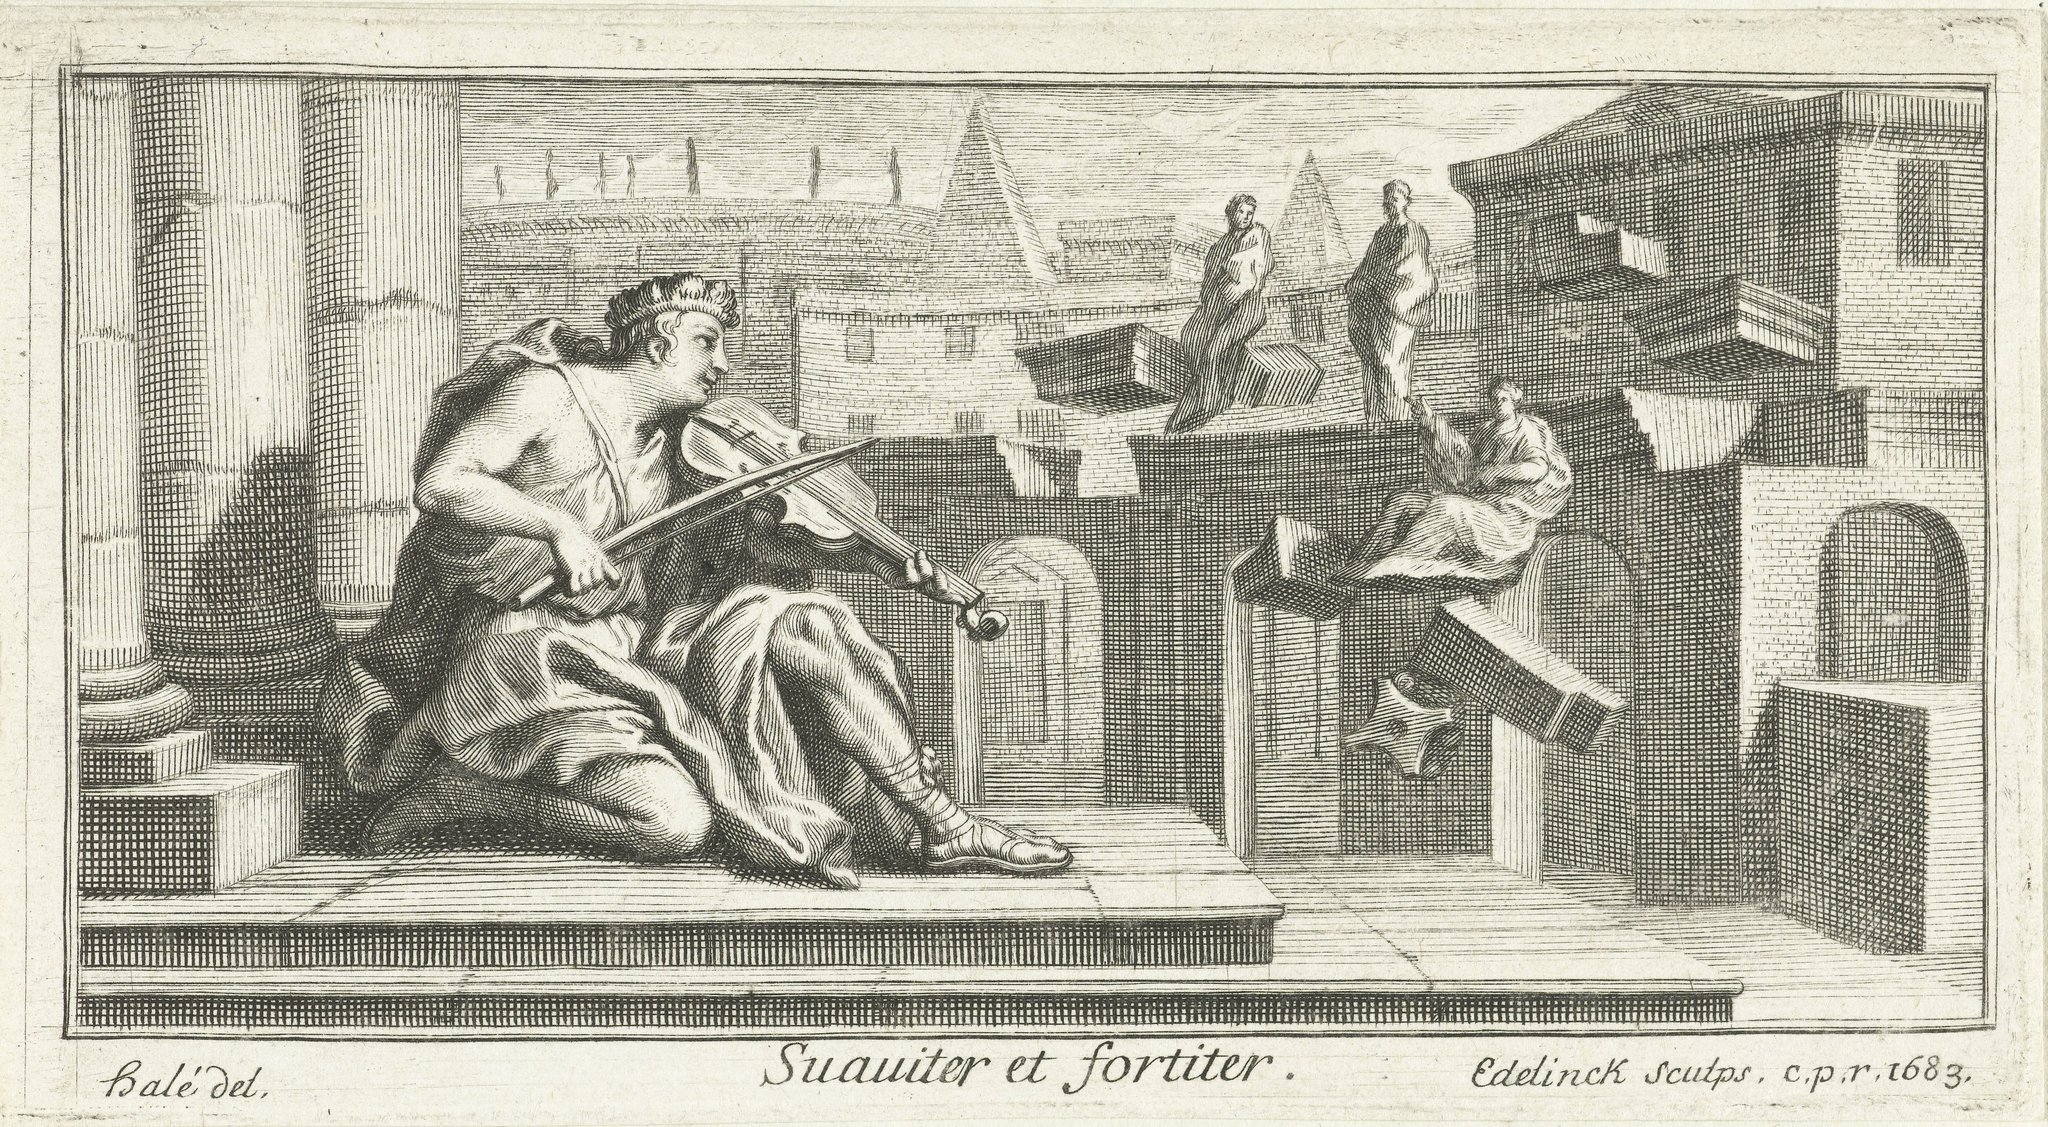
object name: print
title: Suauiter et fortiter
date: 1683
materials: paper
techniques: engraving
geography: paris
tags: amphion and zethus build the walls of thebes; amphion hoists the stones by the music of his lyre, zethus with his hands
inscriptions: collector's mark: Lugt 240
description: Amphion bespeelt zijn viool, waardoor op de achtergrond zwevende elementen de stadsmuren van Thebe vormen.